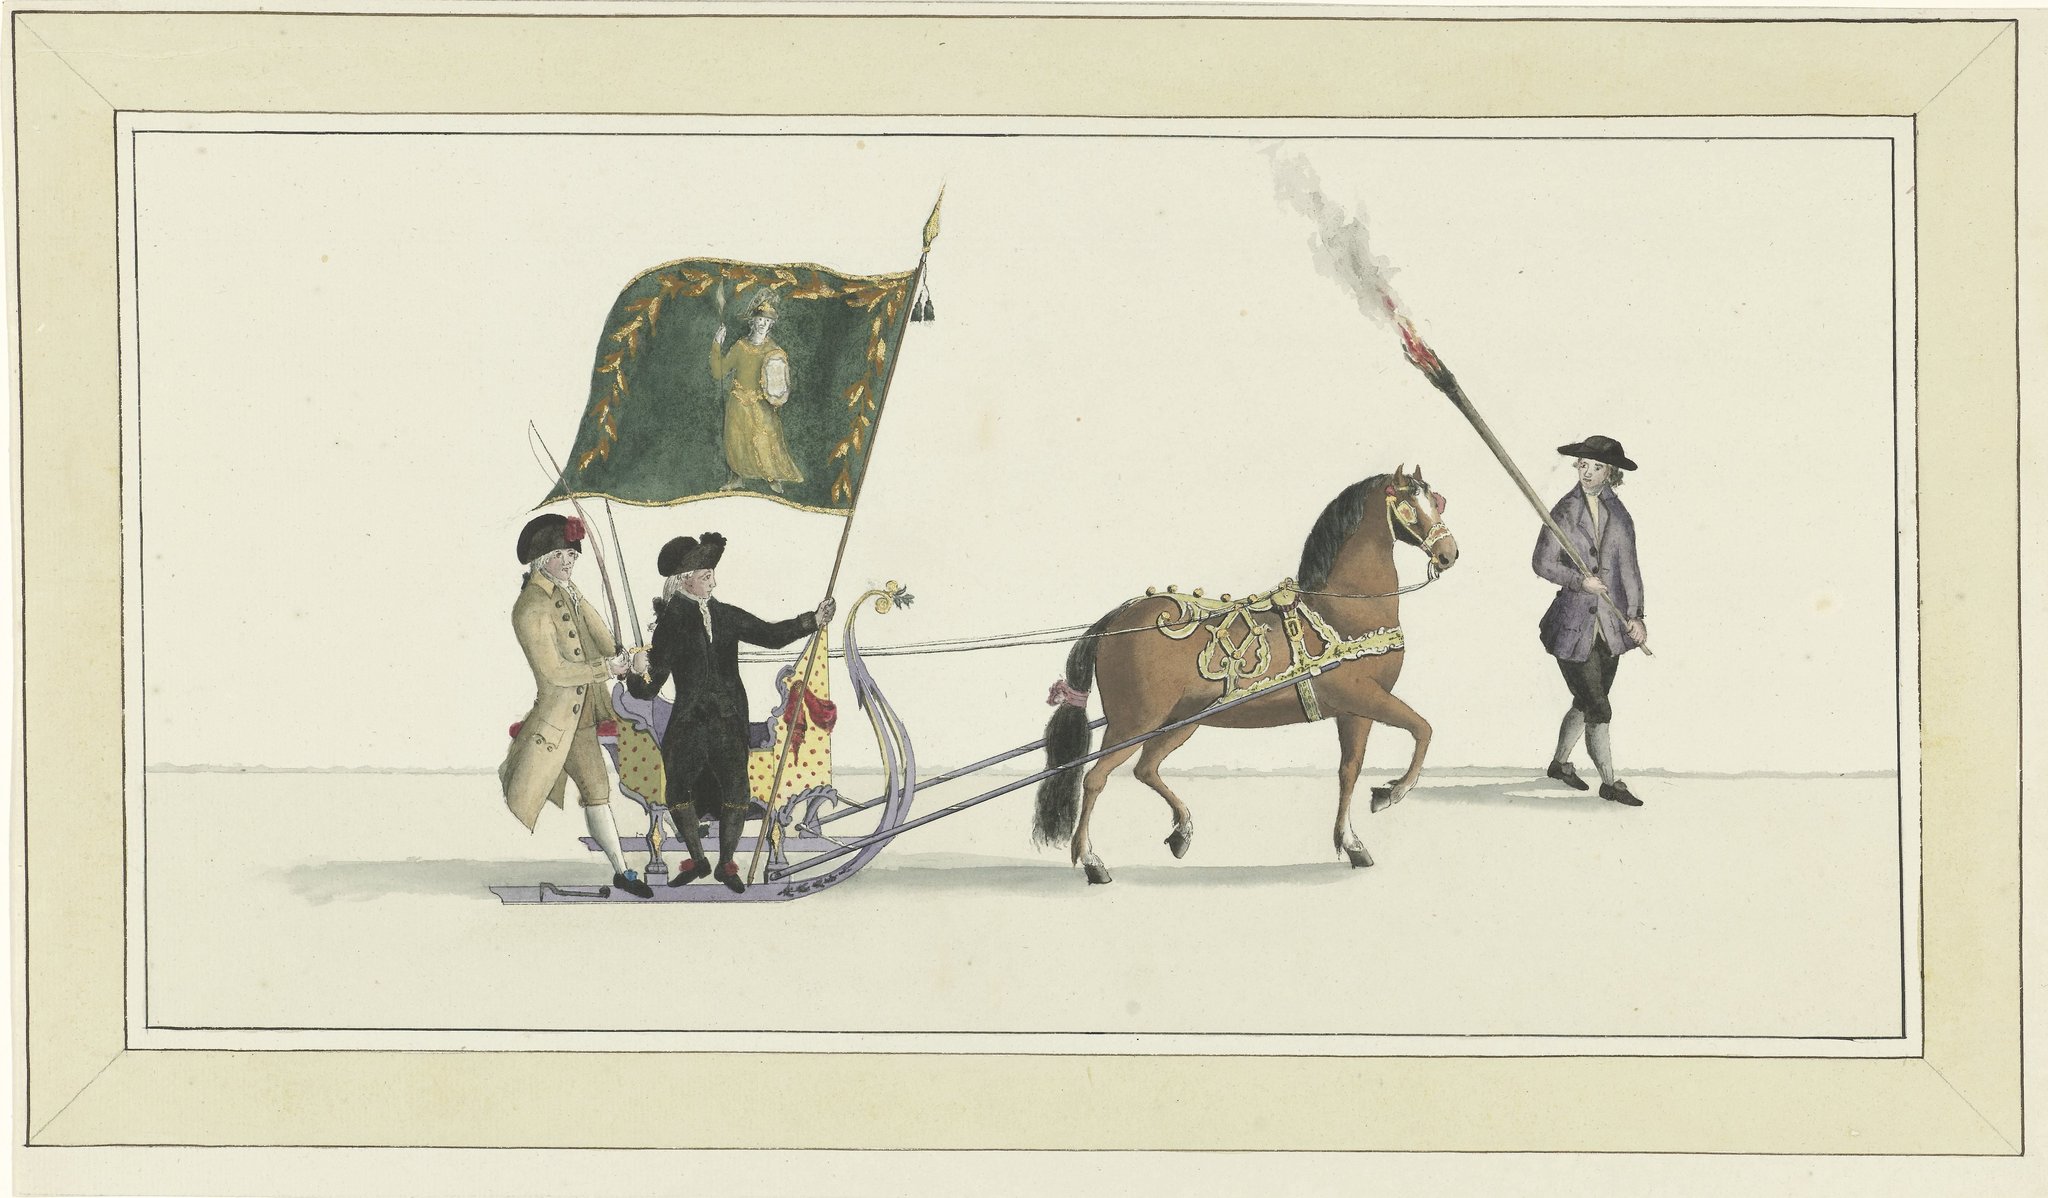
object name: drawing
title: Plegtige Sledevaert, Betrekkelijk de beide tweede Eeuwfeesten der Stad Leyden, en de Stichtinge van 's Lands Hooge Schoole aldaer, door het Tooneelgenootschap onder de spreuk: Veniam Pro Laude, Gehouden op den XXIV van Louwmaand 1776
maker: abraham delfos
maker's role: draughtsman, painter, print maker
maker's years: 1731-1820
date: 1776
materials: paper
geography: northern netherlands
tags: sledge, sleigh (winter sports), commemoration of the founding of a university, leiden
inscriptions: collector's mark: Lugt 2228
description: De twaalfde slede in de optocht. Een slede met een man met een vaandel, getrokken door een paard, voorafgegaan door een man met brandende fakkel. Onderdeel van de reeks van vijftien tekeningen voor de platen van de sledevaart op 24 januari 1776 georganiseerd door het Leidse genootschap Veniam Pro Laude bij gelegenheid van het Tweede Eeuwfeest van het Leids Ontzet (3 oktober 1574) en de oprichting van de Universiteit van Leiden (8 februari 1575). Deze tekening niet in prent gebracht.